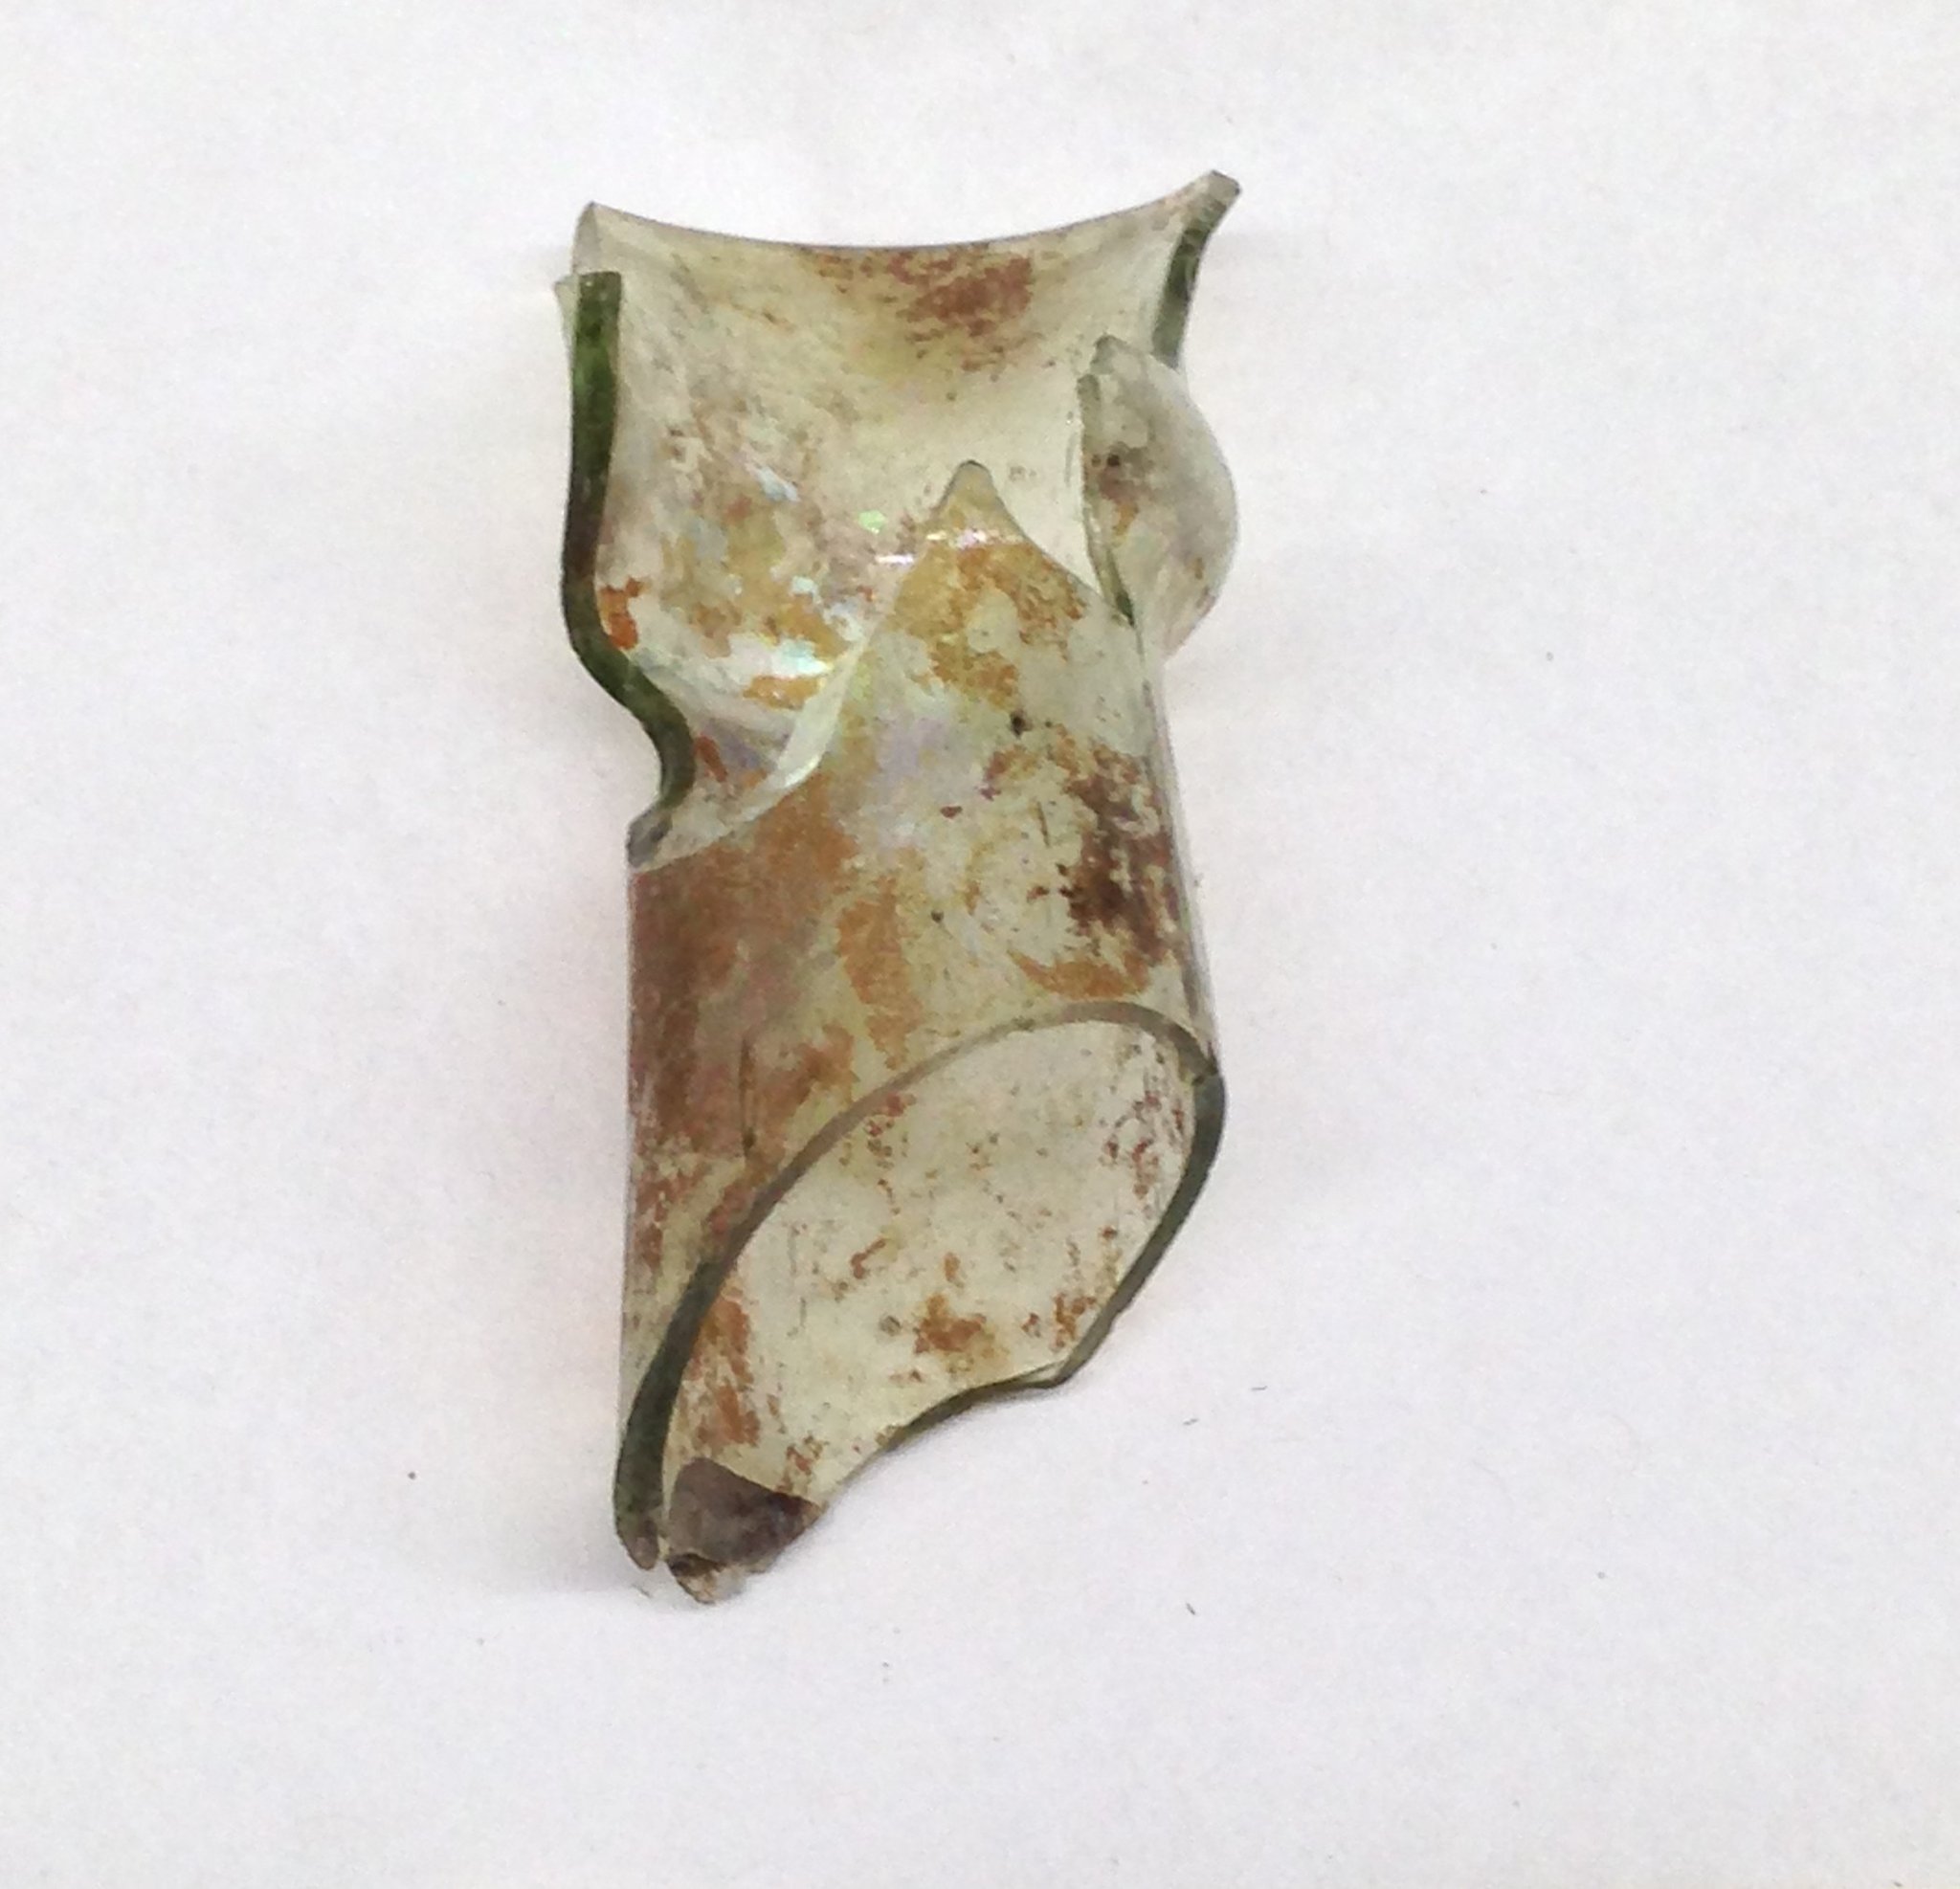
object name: fragment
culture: european or middle eastern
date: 1150-1250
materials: ceramic, glass